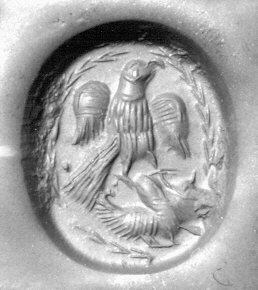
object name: stamp seal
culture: sasanian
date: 201-700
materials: onyx, gemstone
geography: iran or mesopotamia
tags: birds